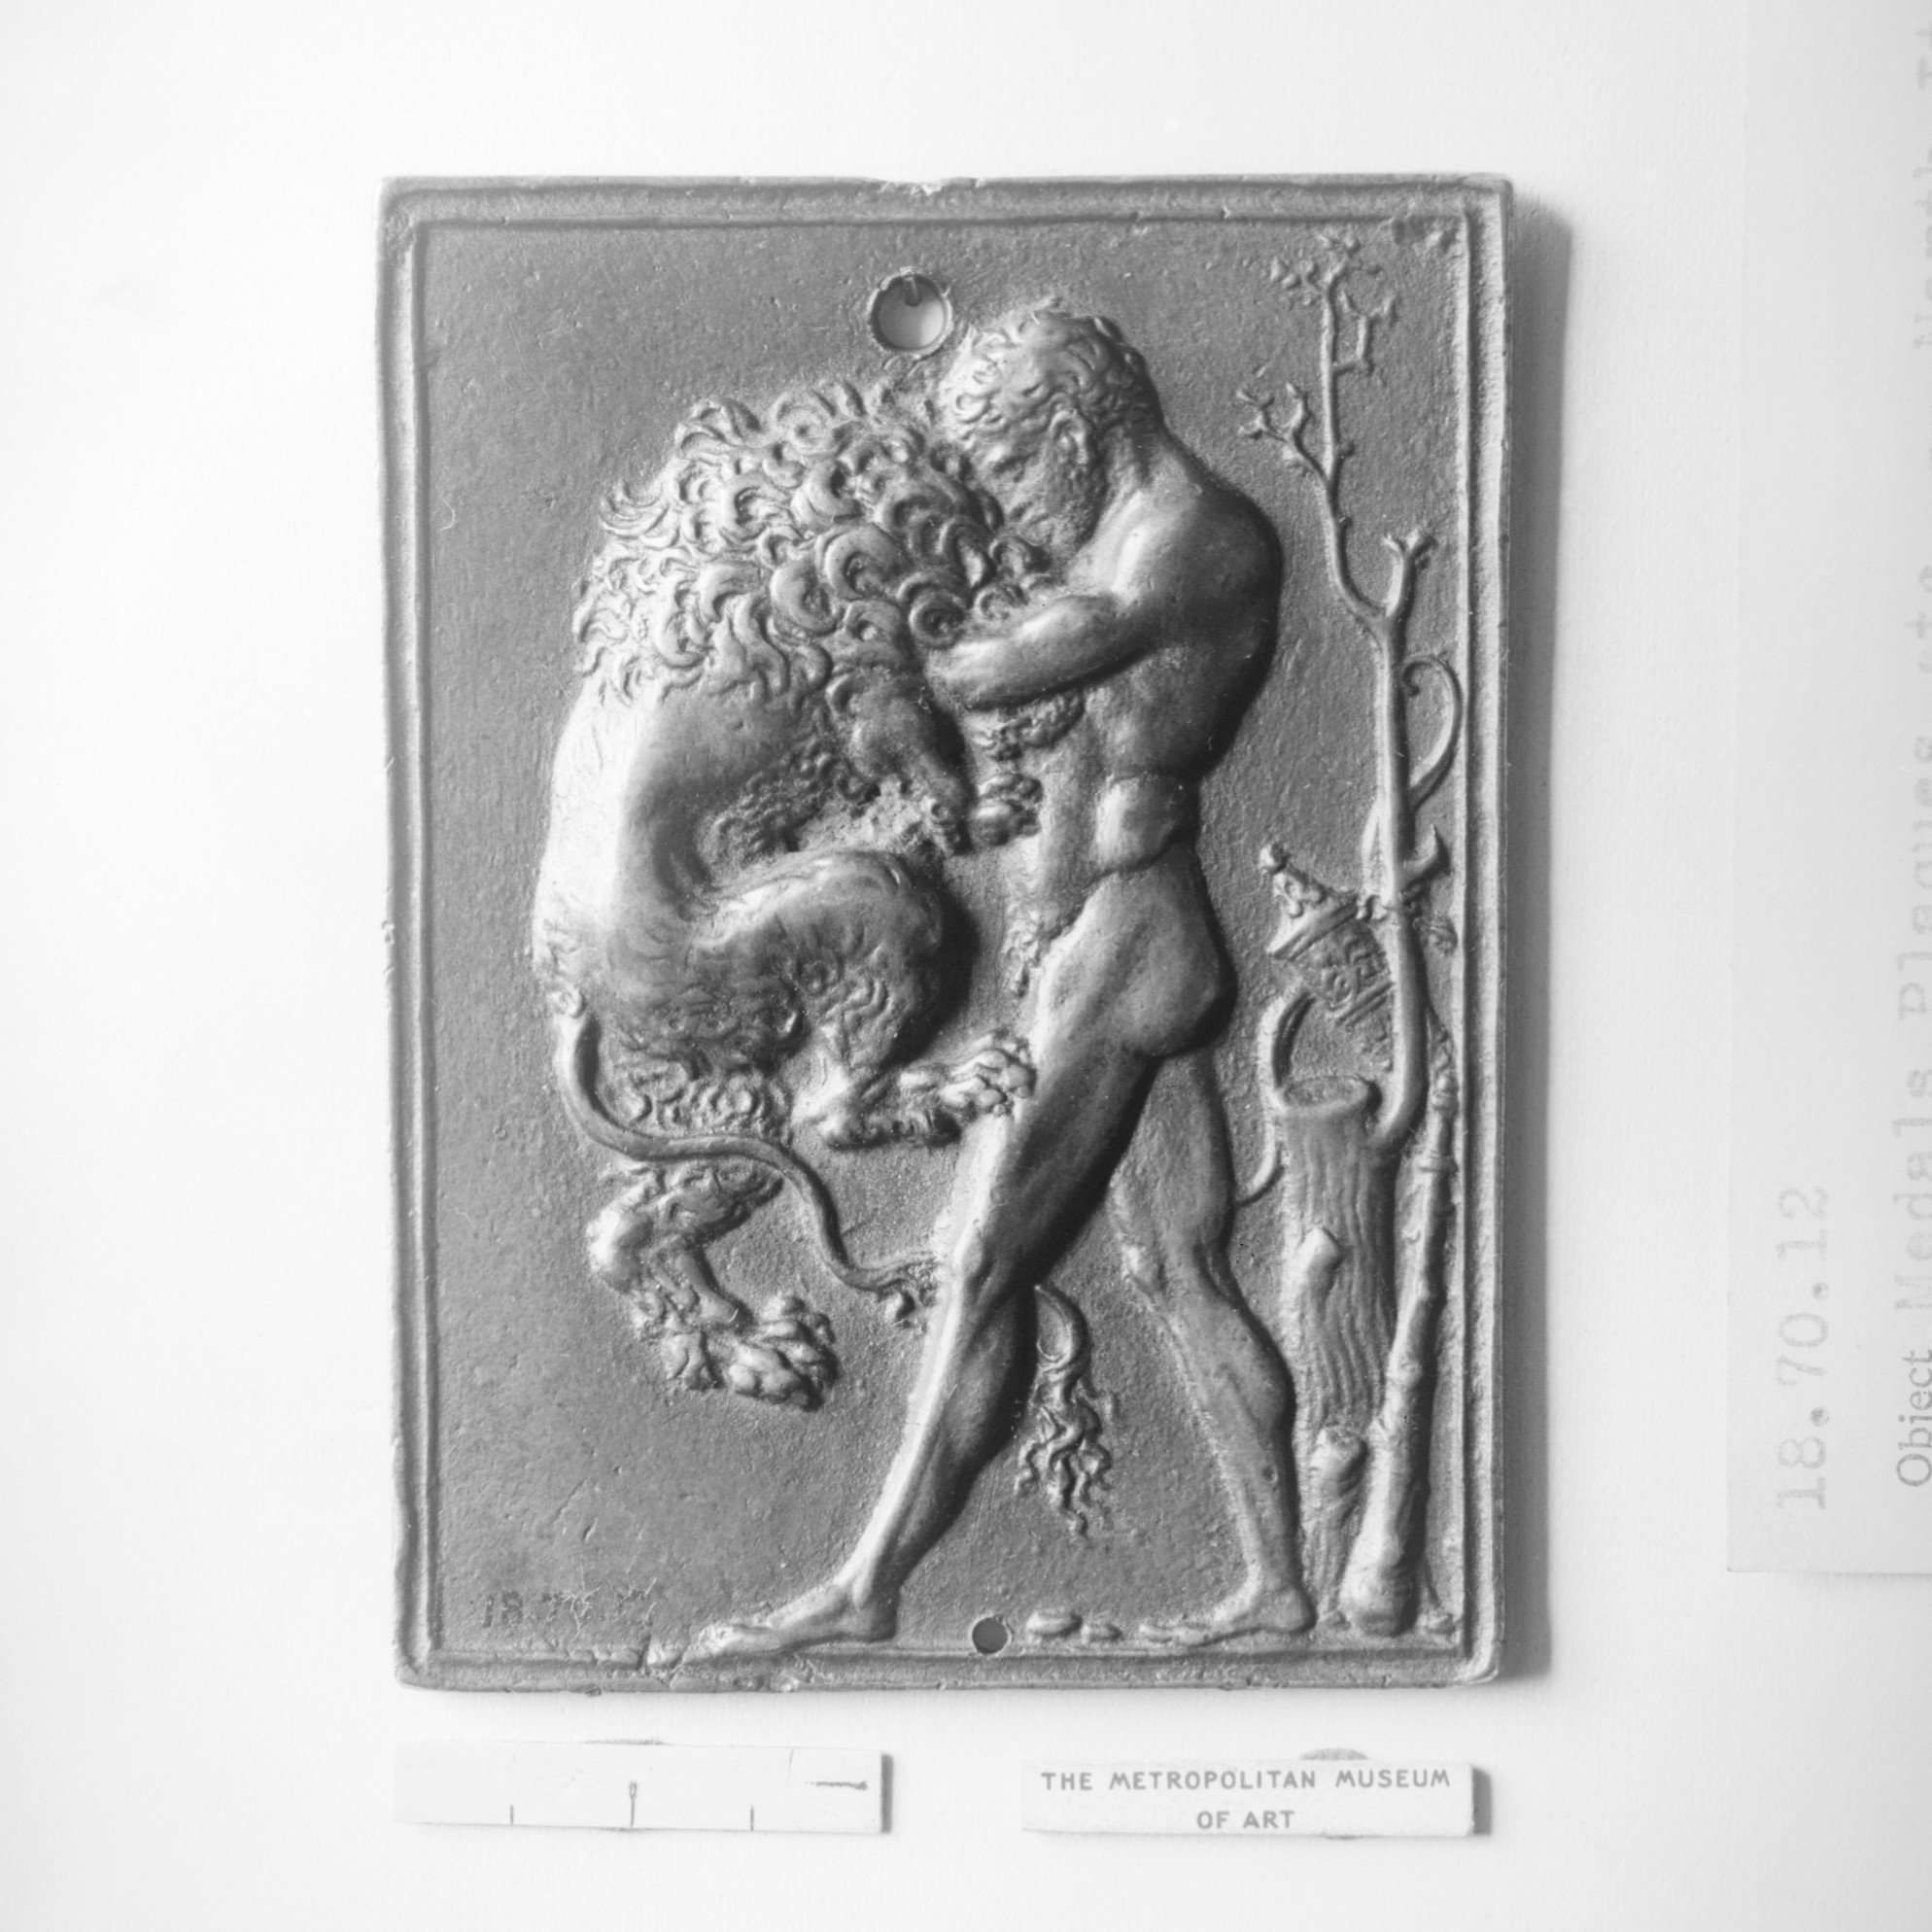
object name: plaquette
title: Hercules strangling the Nemean lion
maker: moderno (galeazzo mondella)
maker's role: maker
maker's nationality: italian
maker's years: 1467-1528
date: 1501-1600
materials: bronze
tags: hercules,lions